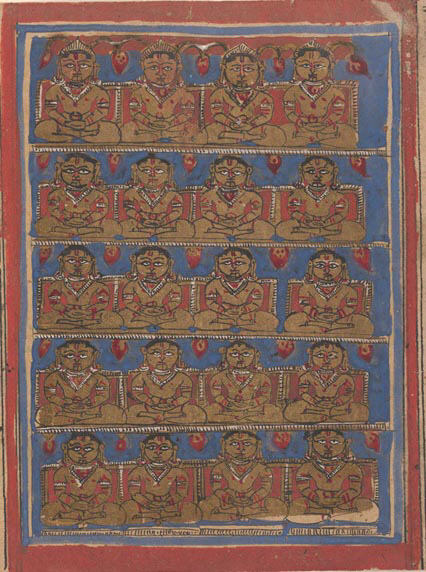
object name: folio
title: Twenty Tirthankaras: Folio from a Kalpasutra Manuscript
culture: indian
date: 1401-1500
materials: gold, ink, paper, watercolor